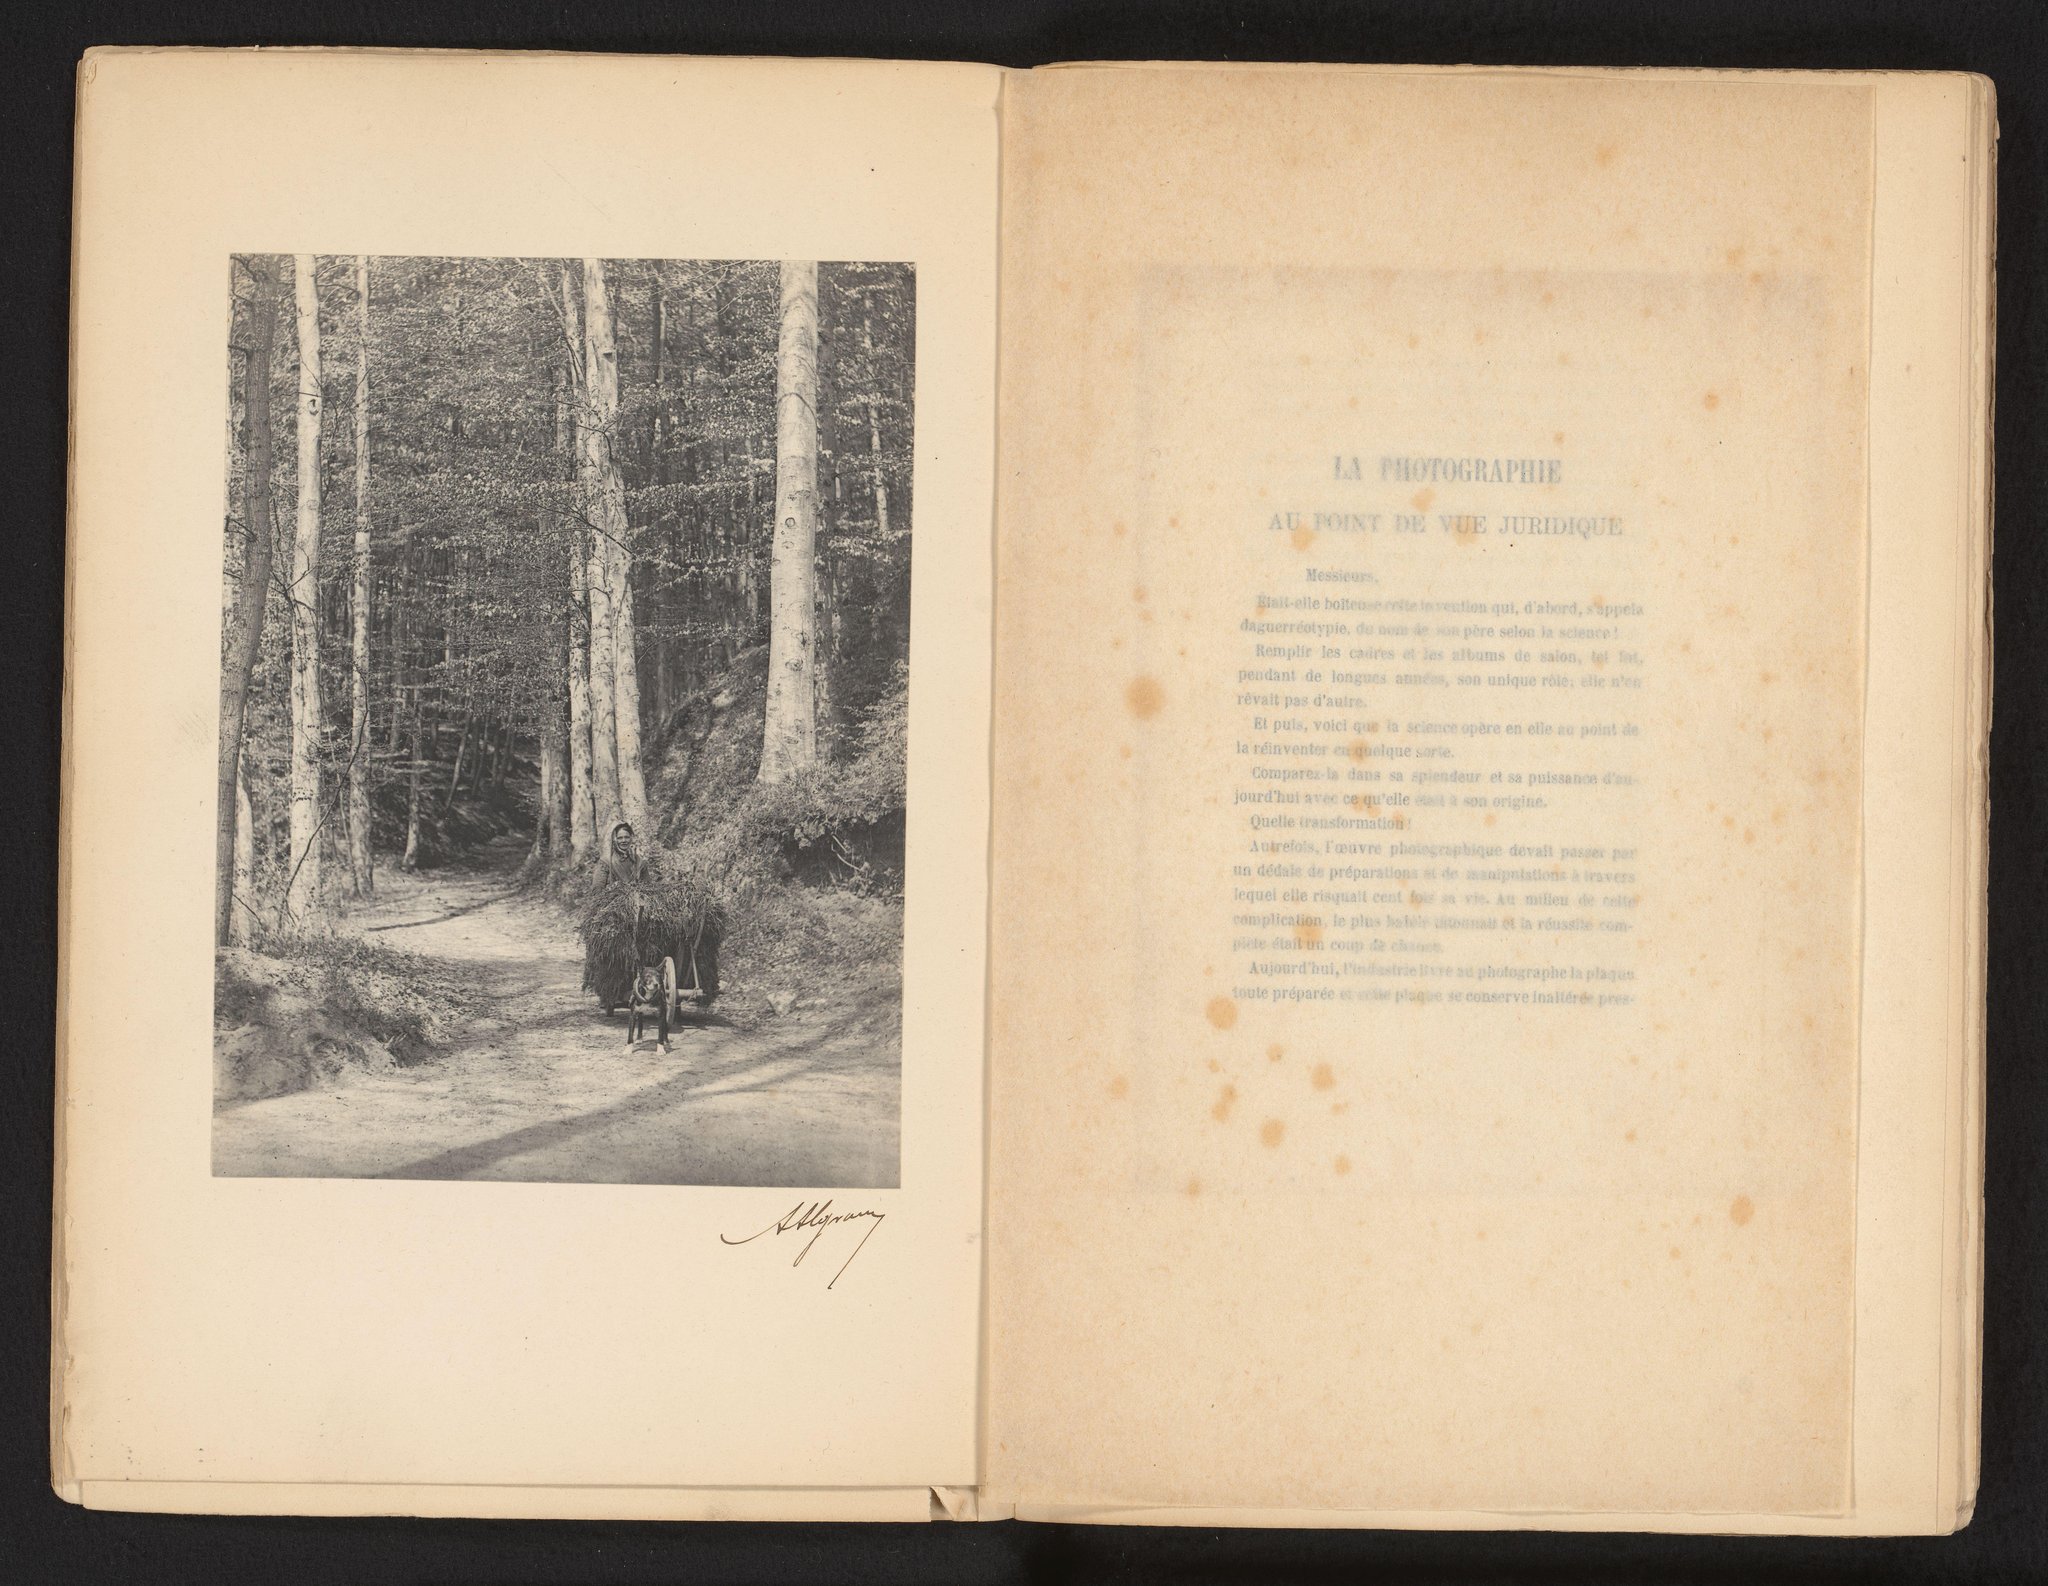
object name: page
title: Gezicht op een onbekende vrouw met een kar en een hond op een bospad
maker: alfred algrain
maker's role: fotograaf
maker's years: -1917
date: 1885-1890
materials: paper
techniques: platinum process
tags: hand-cart, historical persons, forest path or lane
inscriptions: signature: ‘Algrain’